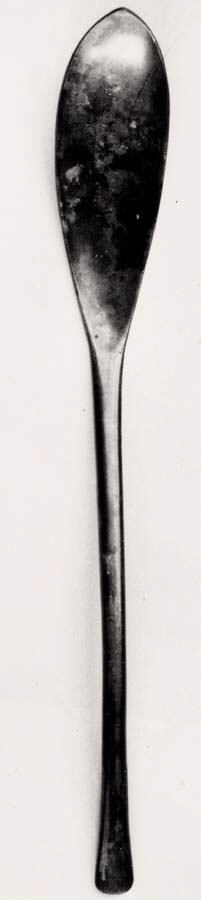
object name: spoon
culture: korean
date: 918-1392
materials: bronze